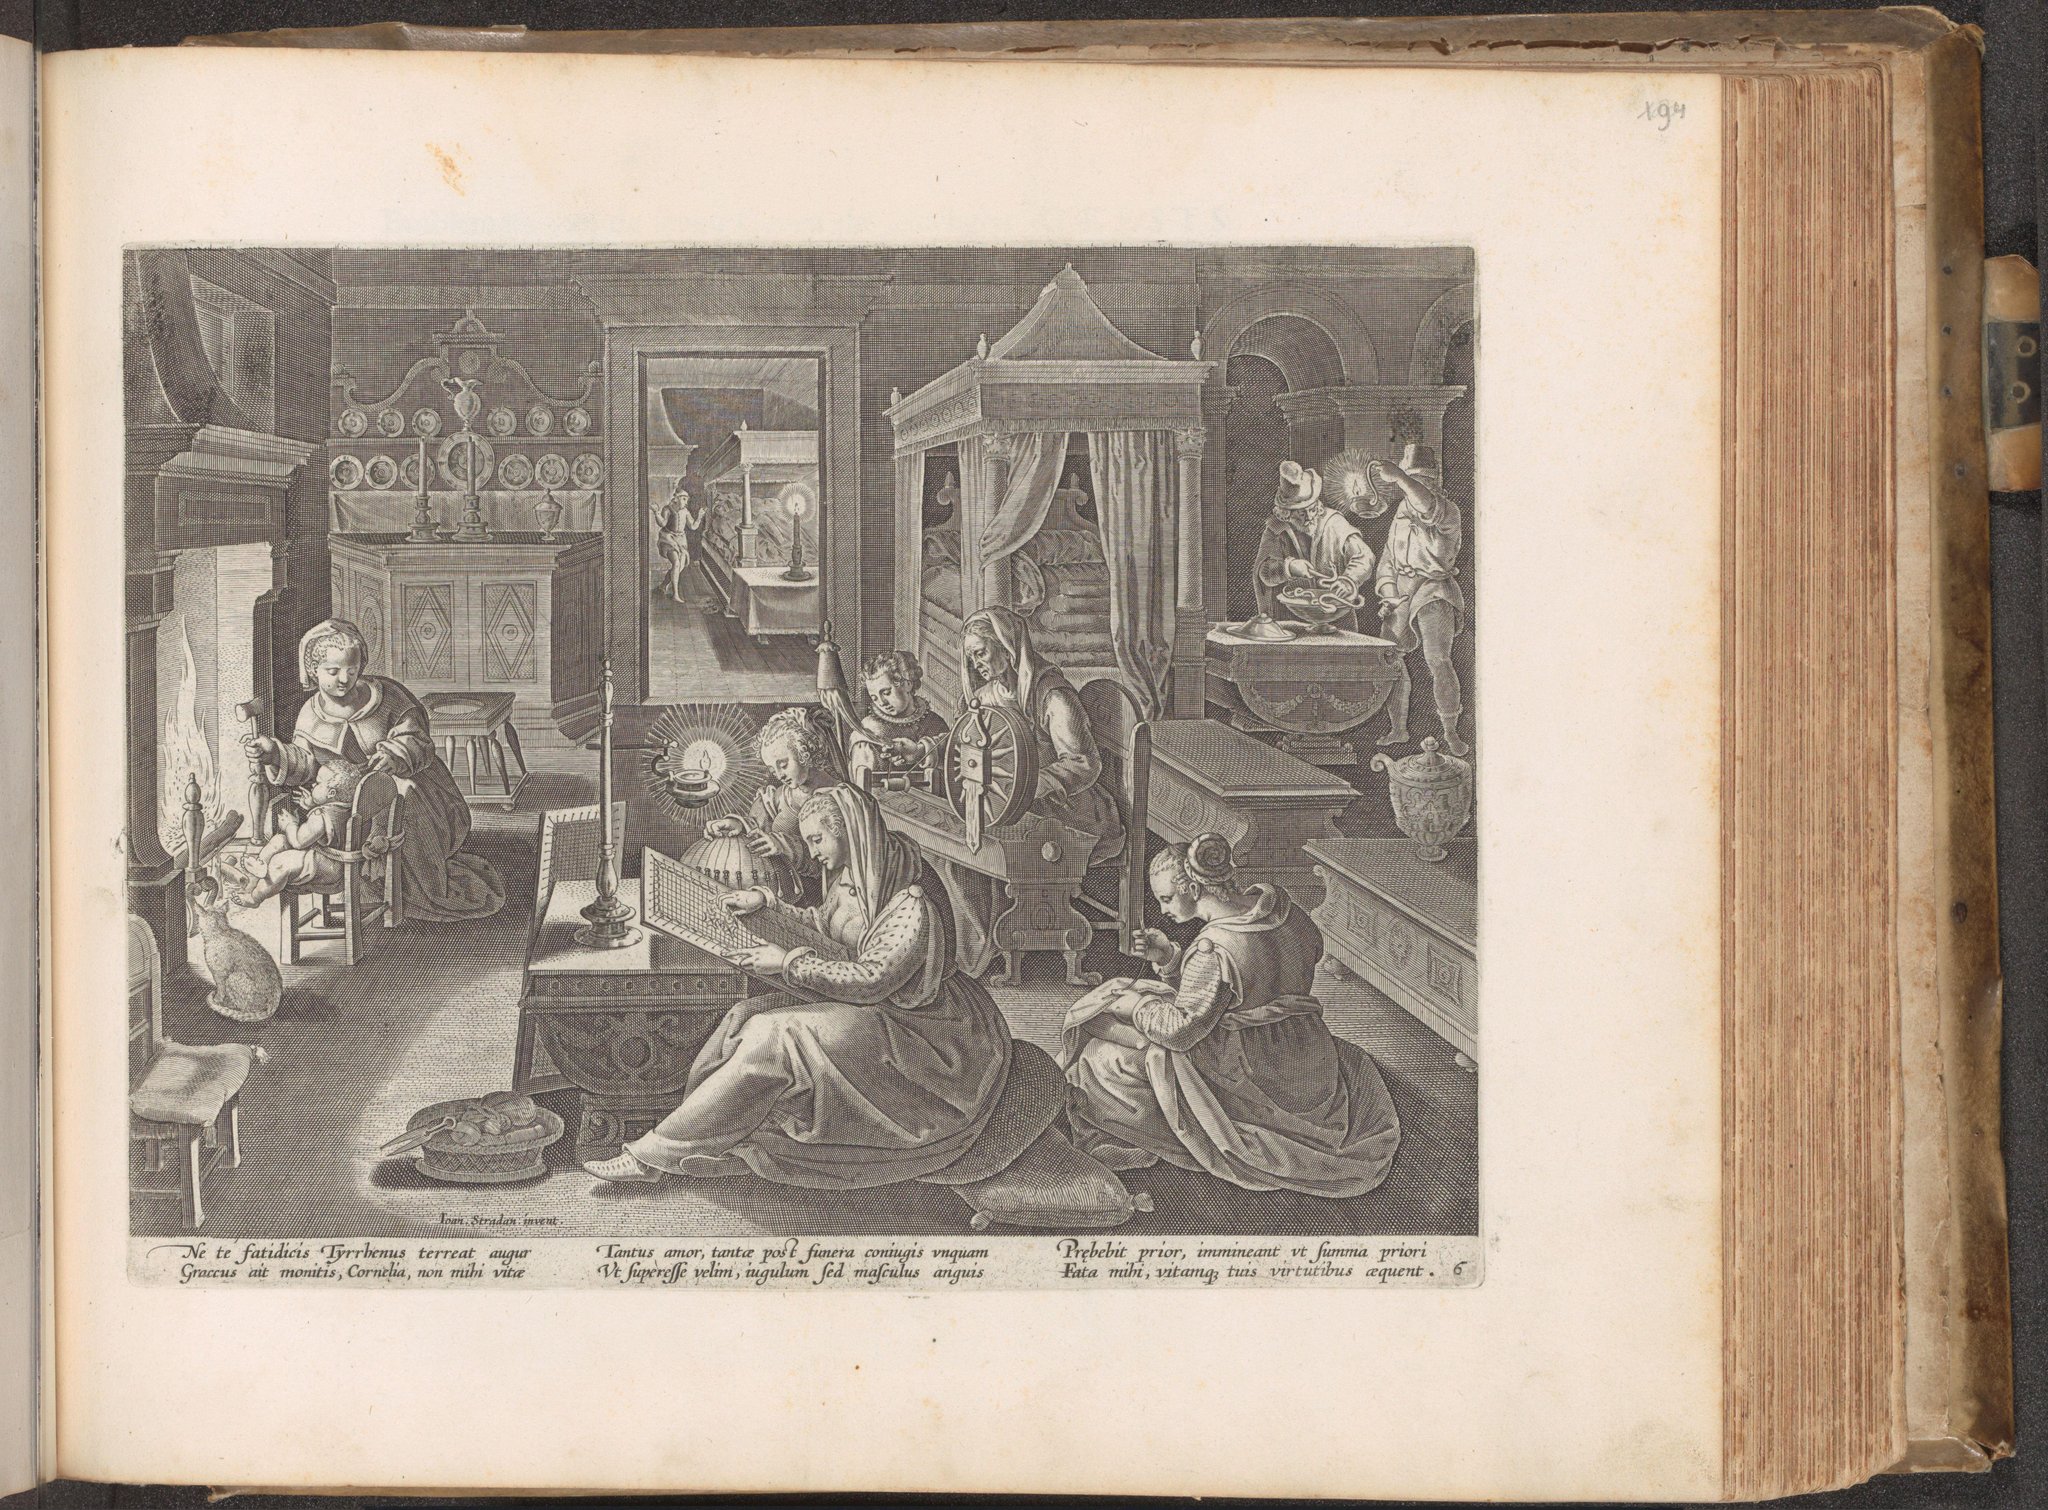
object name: album leaf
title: Beroemde Romeinse vrouwen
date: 1653-1654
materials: paper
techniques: engraving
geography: amsterdam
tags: (story of) cornelia, mother of the gracchi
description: Cornelia, vrouw van Tiberius Gracchus en moeder van de gebroeders Gracchi als deugdzame huisvrouw. Zij wordt voorgesteld als een goede moeder die met haar kind speelt en als een vlijtige huisvrouw die zich bezighoudt met borduren, spinnen, kantklossen en naaien. Op de achtergrond rechts doodt haar man Tiberius een slang. Met een onderschrift in drie kolommen in het Latijn. De prent maakt deel uit van een album.